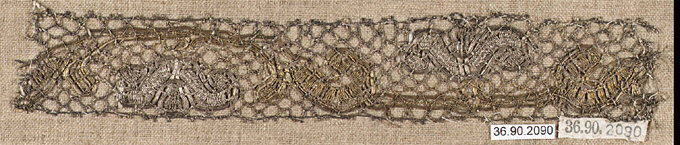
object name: piece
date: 1801-1900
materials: metal thread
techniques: lace